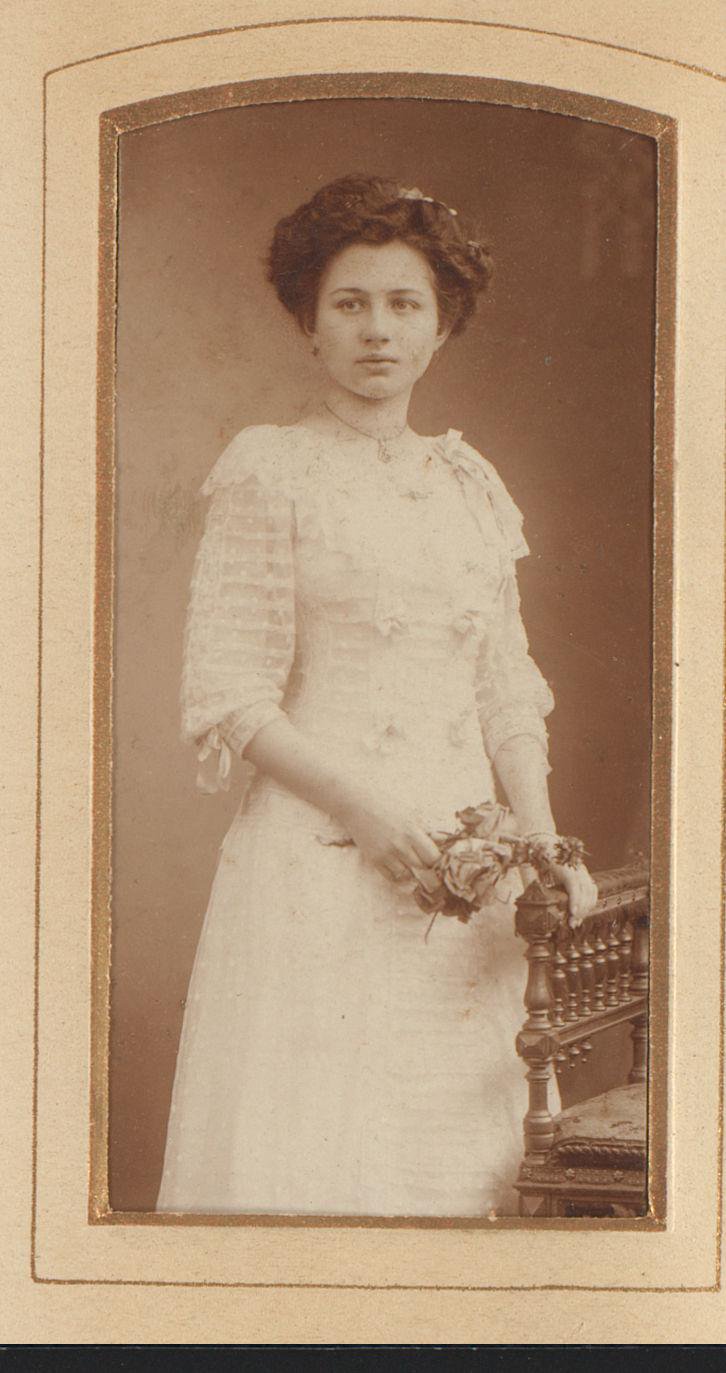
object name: album leaf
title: Portret van een jonge vrouw met bloemen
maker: Anonymous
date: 1890-1920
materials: cardboard, photographic support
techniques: collodion silver print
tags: cut flowers; nosegay, bunch of flowers, historical persons - bb - woman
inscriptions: inscription: ‘[...] Rheinstr. 31’